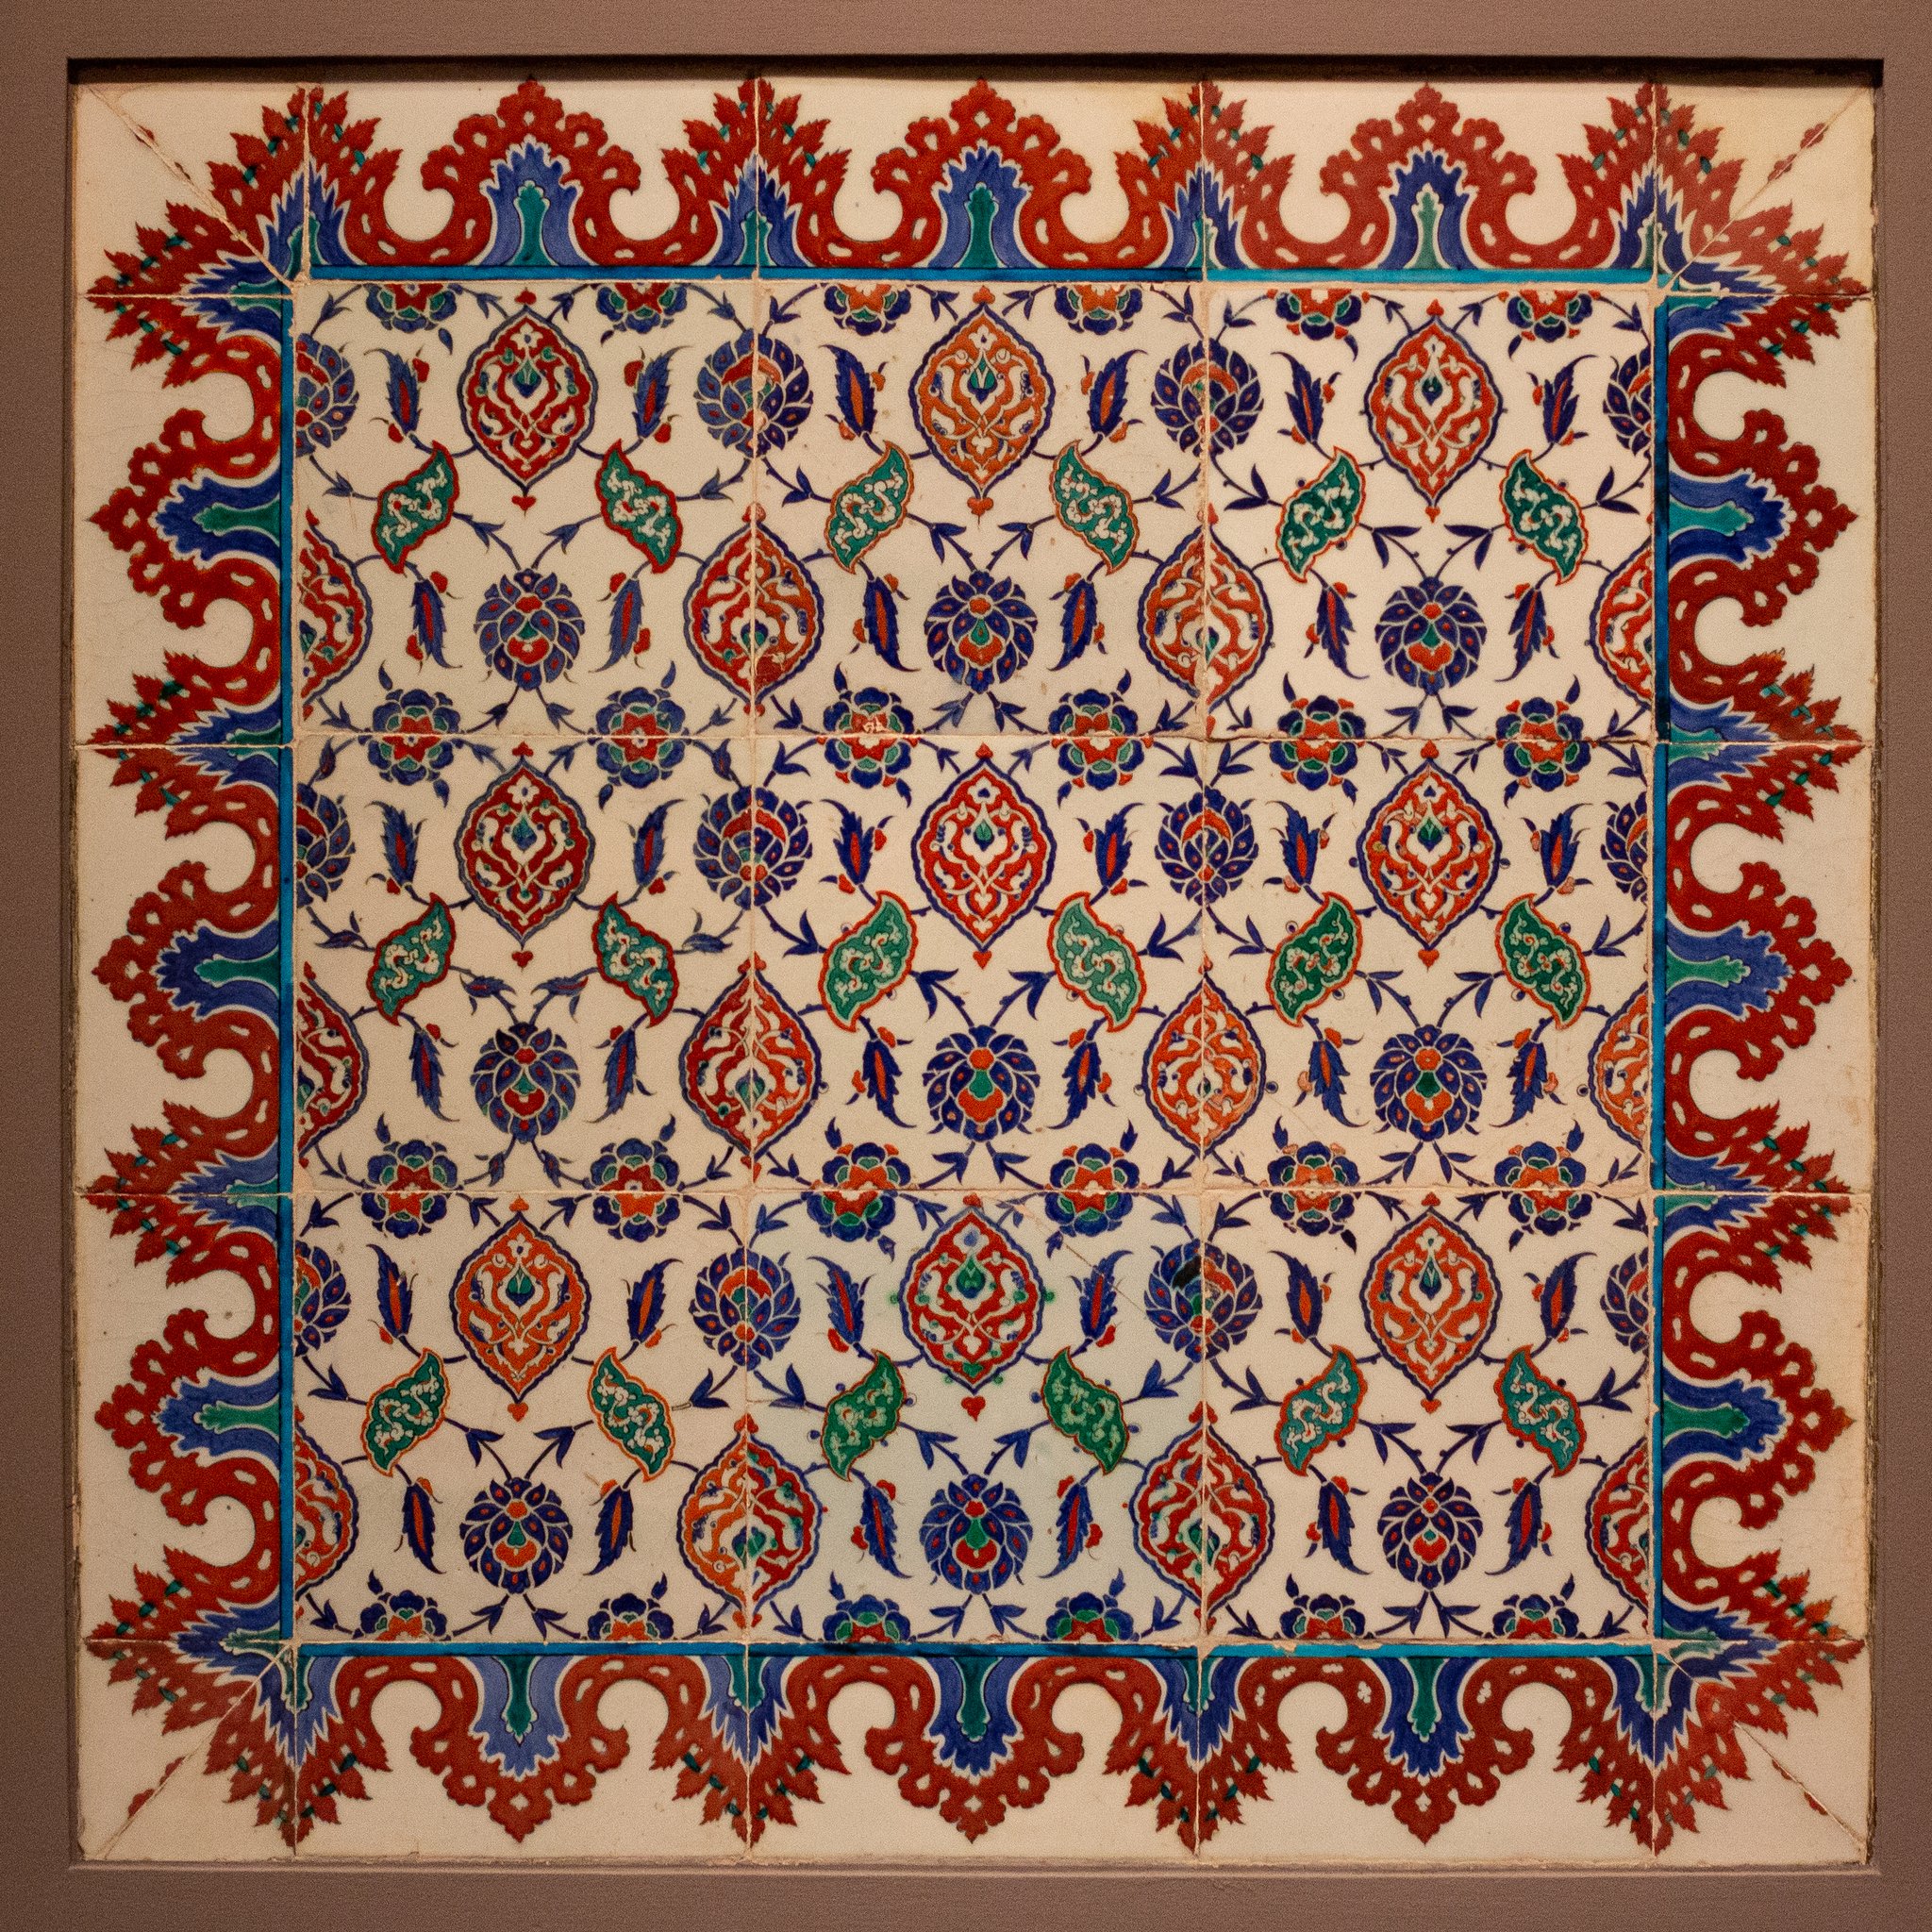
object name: tile panel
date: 1551-1600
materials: glaze, stonepaste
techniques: painting, polychrome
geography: turkey